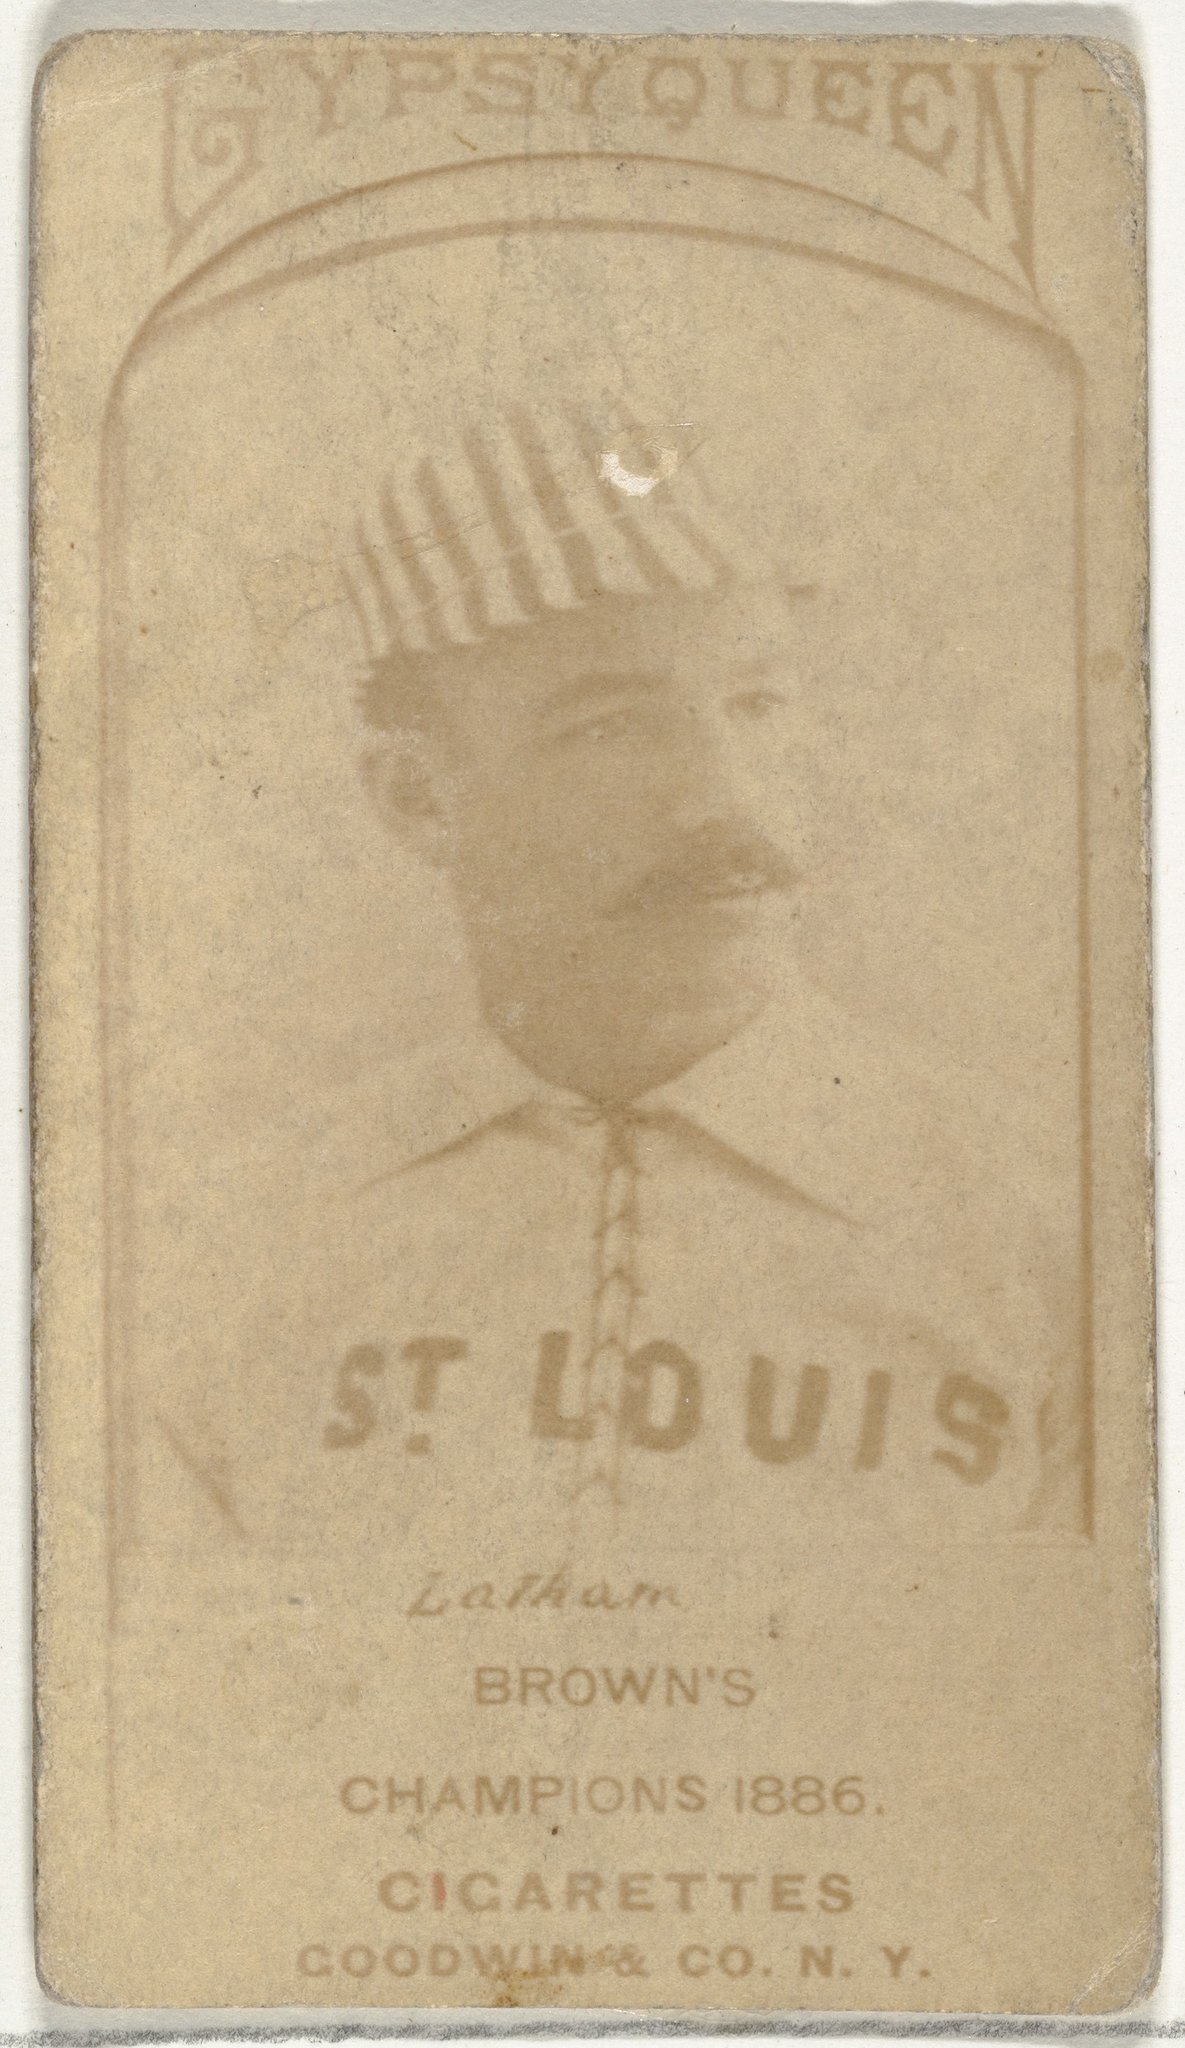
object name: baseball card, photograph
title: Arlie Latham, 3rd Base, St. Louis Browns, from the Old Judge series (N172) for Old Judge Cigarettes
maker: goodwin & company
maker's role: publisher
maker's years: 1850-1950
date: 1886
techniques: albumen silver print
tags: men,portraits,baseball,athletes